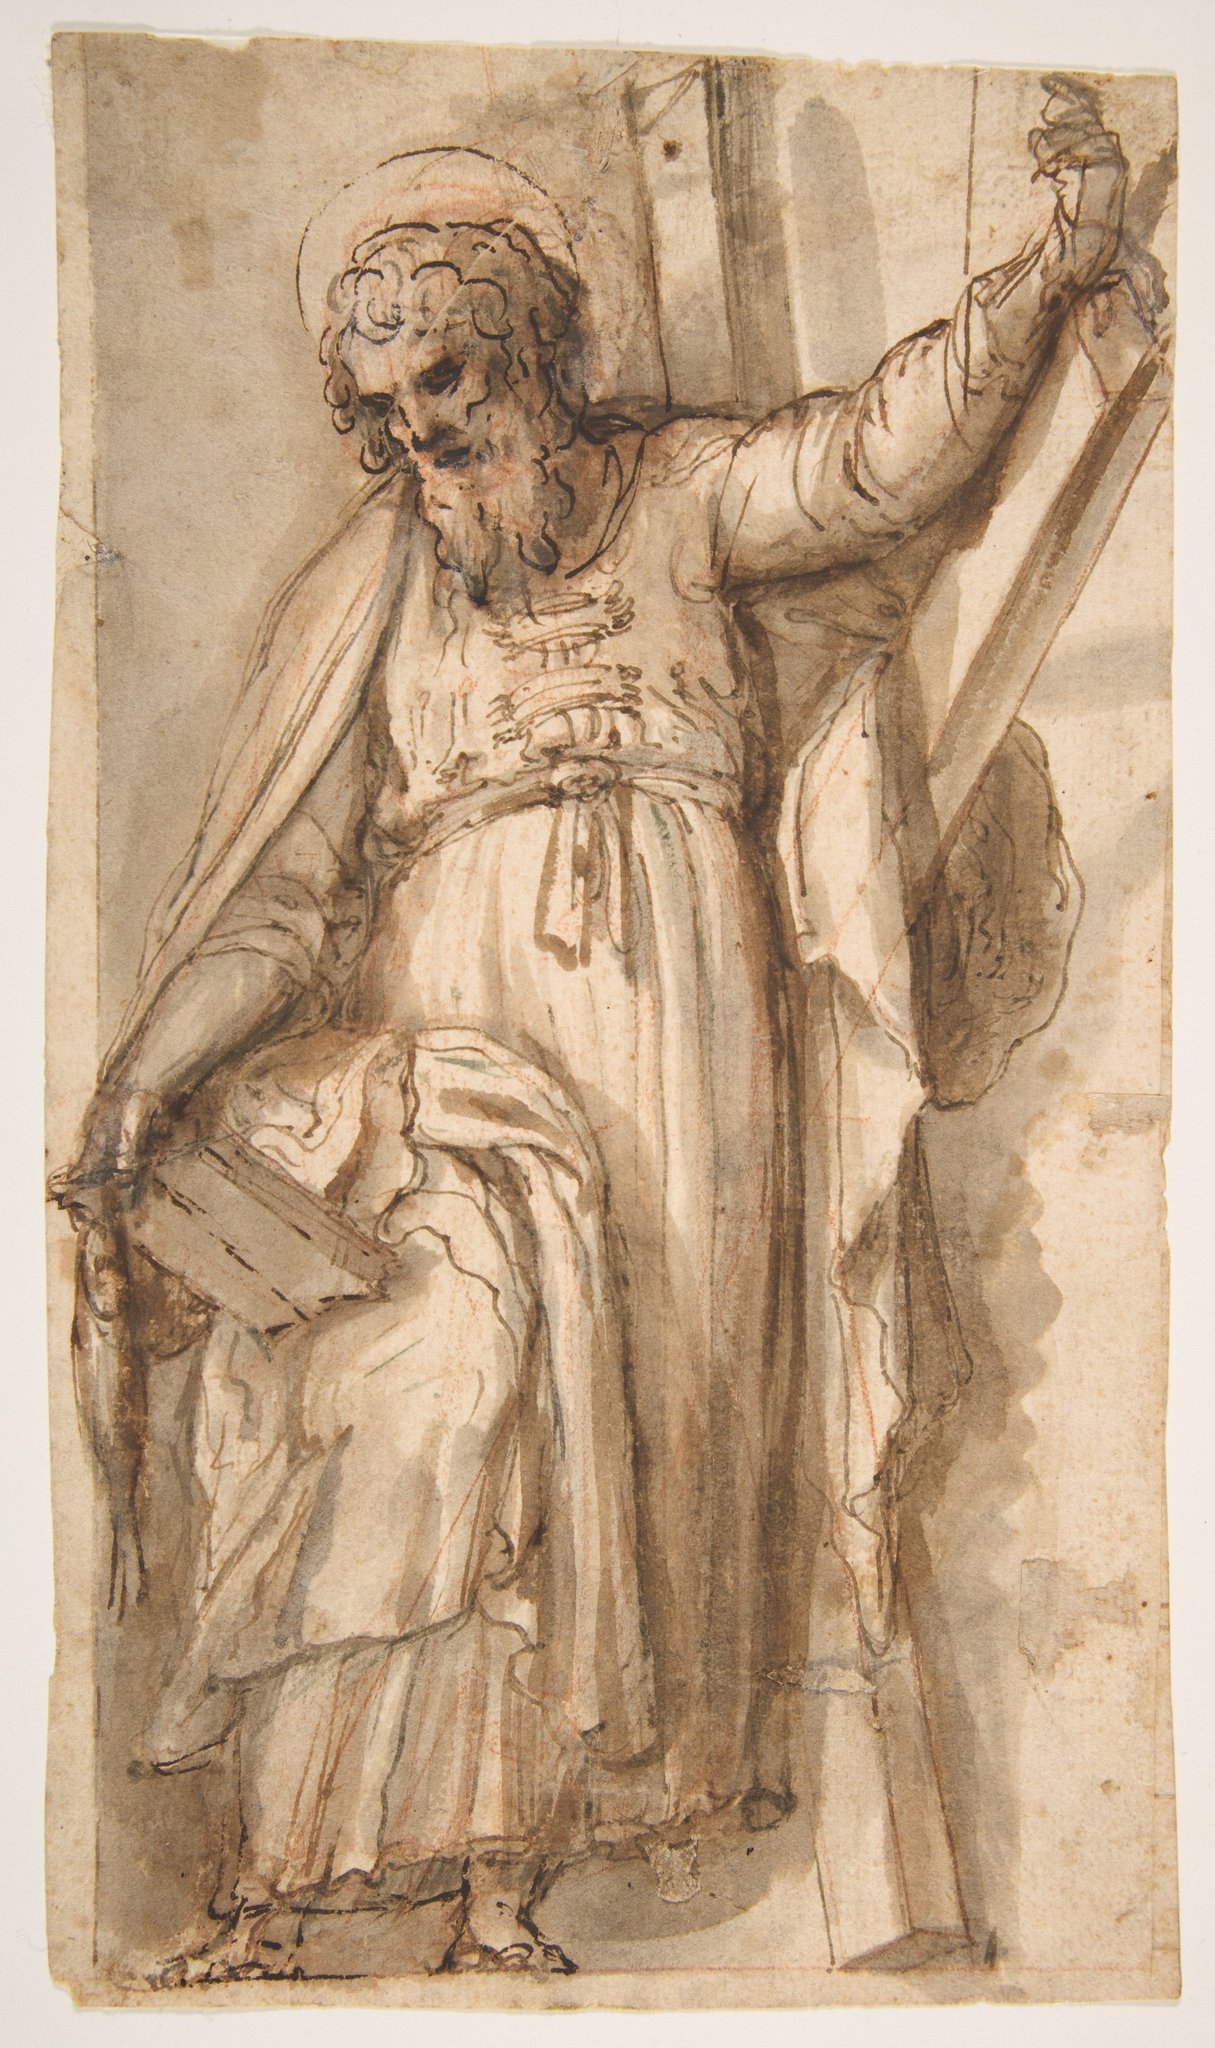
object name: drawing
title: Saint Andrew, Apostle, with Transverse Cross, Book, and Fish, (recto); Architectural sketch (verso)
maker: fabrizio santafede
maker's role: artist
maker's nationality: italian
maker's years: 1576-1623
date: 1576-1623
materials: chalk, ink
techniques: brush, pen, wash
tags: apostles,cross,saints